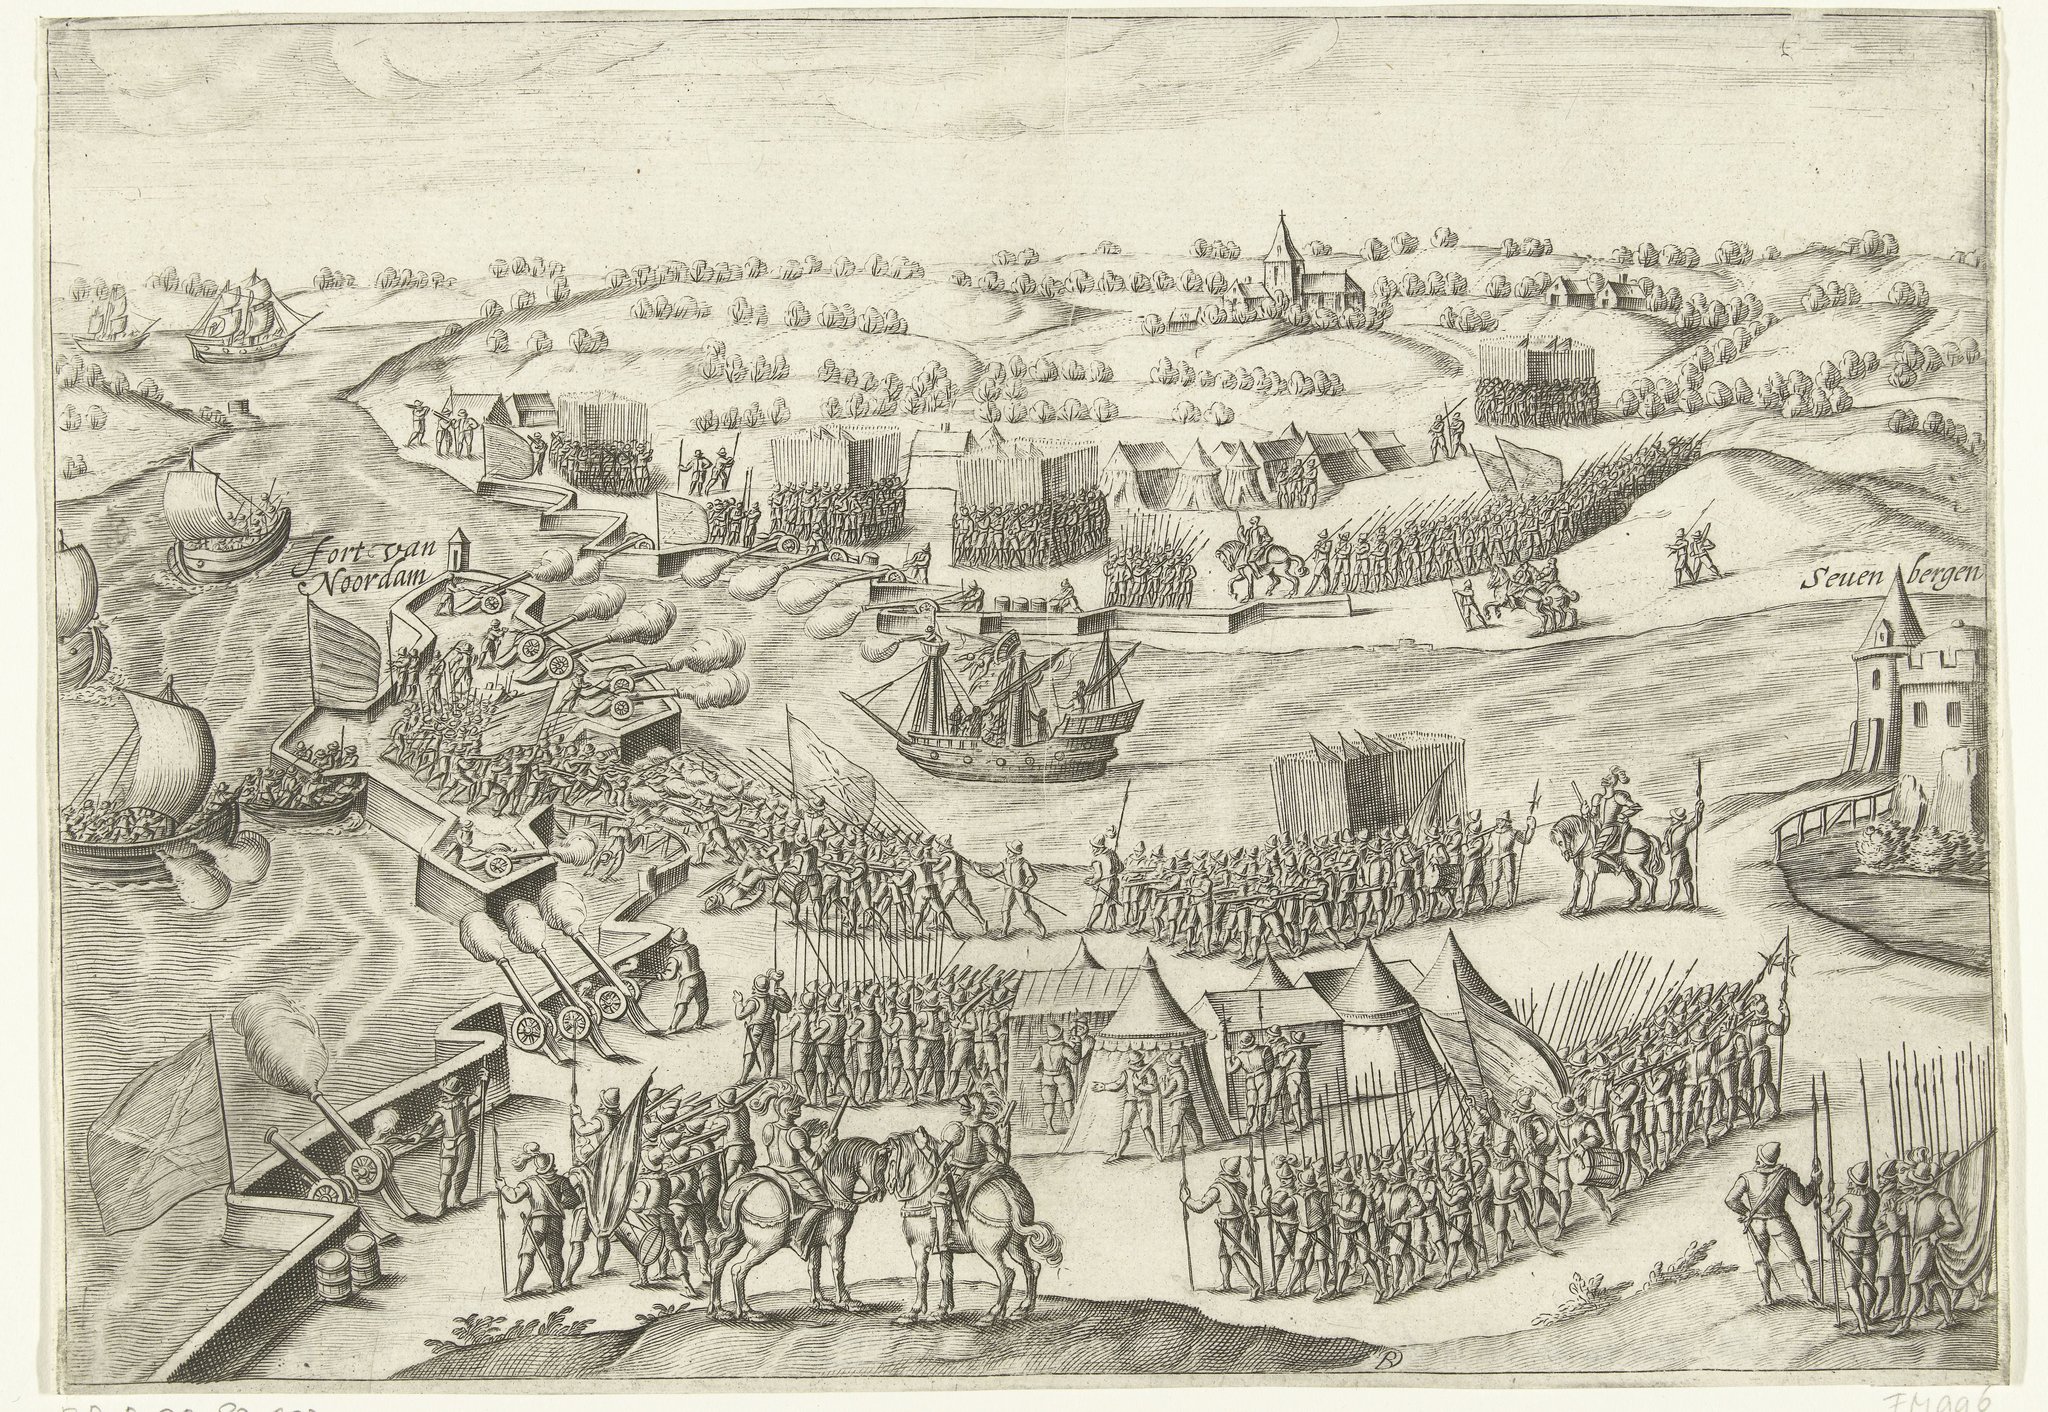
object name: history print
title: Verdediging van het fort Noordam, 1591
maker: bartholomeus willemsz. dolendo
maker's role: print maker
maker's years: 1560-1626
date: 1600-1601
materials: paper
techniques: engraving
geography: northern netherlands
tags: siege, position war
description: Gebruikt als illustratie in: J.J. Orlers, Den Nassauschen Lauren-Crans: Beschrijvinghe ende af-beeldinge van alle de victorien ... die Godt Almachtich de ... Staten der Vereenichde Nederlanden verleent heeft, deur het wijs ende clouck beleyt des Hooch-ghebooren Fursts Maurits van Nassau, J.J. Orlers en H. van Haestens, Leiden 1610, fol. 76/77.